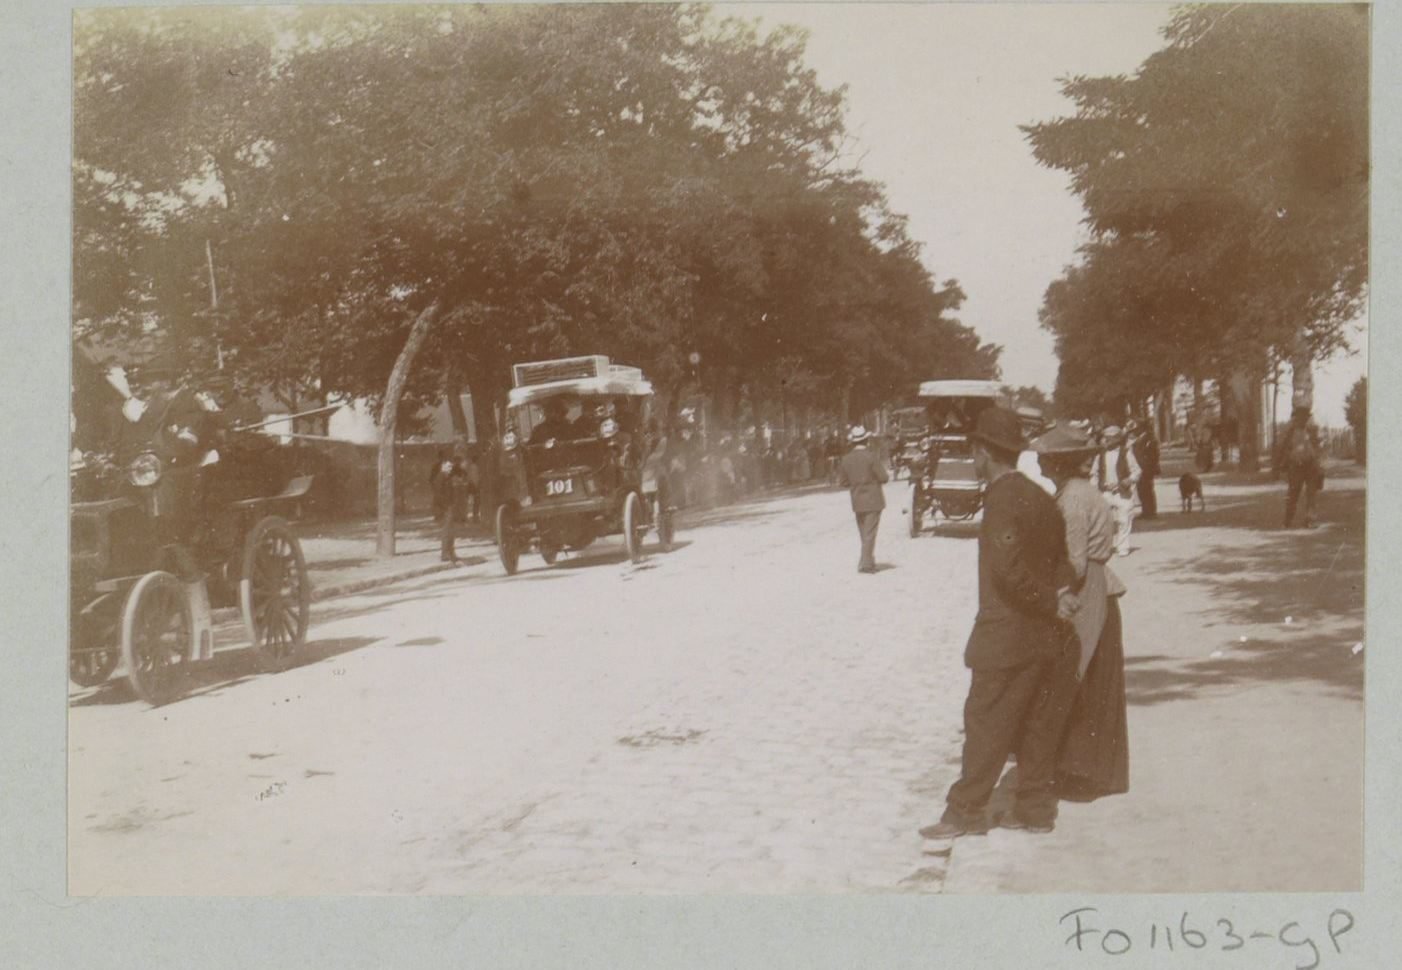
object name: photograph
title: Start van de race Parijs-Amsterdam voor automobielen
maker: delizy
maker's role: manufacturer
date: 1898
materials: paper, photographic support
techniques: gelatin silver print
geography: paris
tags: motorcar racing, automobile, street (+ city(-scape) with figures, staffage), paris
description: Onderdeel van Fotoalbum van een Franse amateurfotograaf met opnames van uitstapjes in Frankrijk, Spanje, België, Luxemburg en Nederland, de eerste automobielen en autoraces.